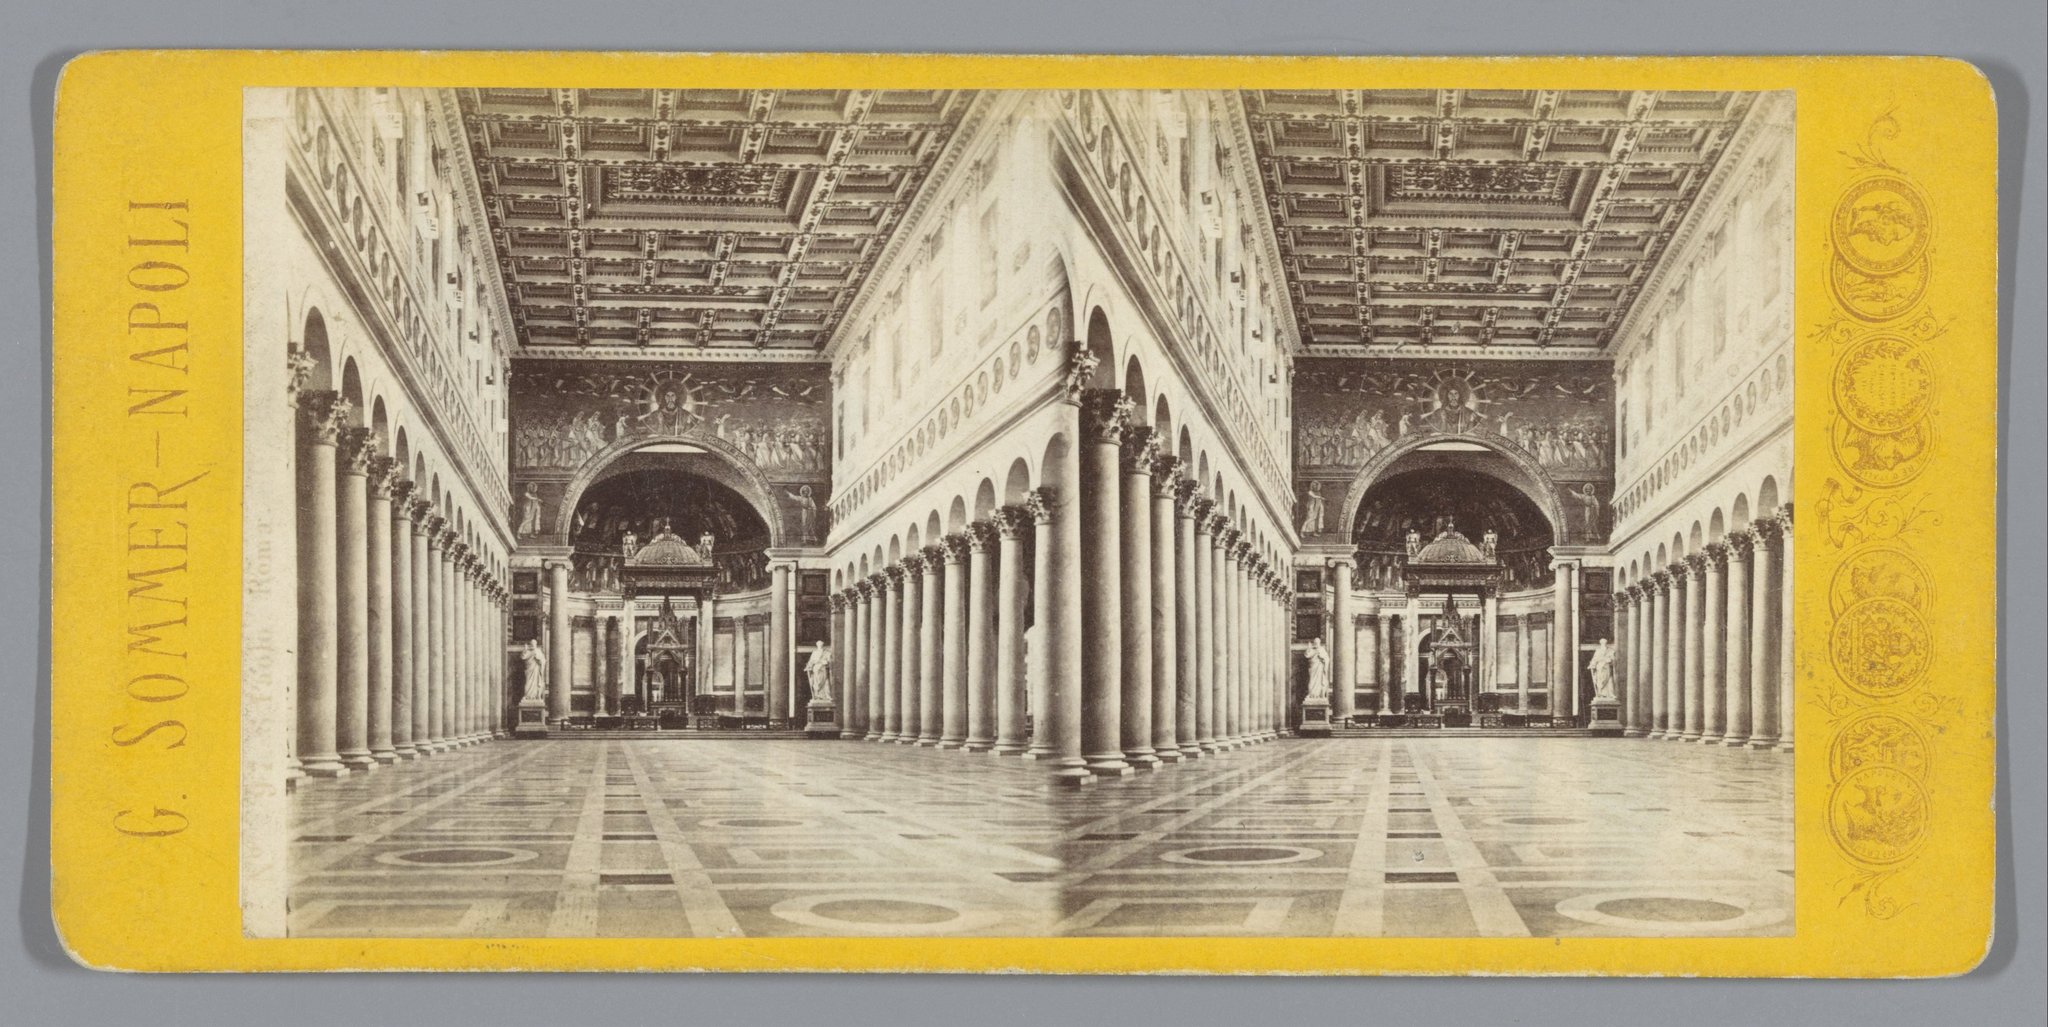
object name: stereograph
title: S. Paolo, Roma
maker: giorgio sommer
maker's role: fotograaf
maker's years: 1834-1914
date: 1860-1880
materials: cardboard, photographic support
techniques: albumen print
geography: rome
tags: interior of church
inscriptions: inscription: ‘Roma : S. Paolo’, number: ‘No. 97’